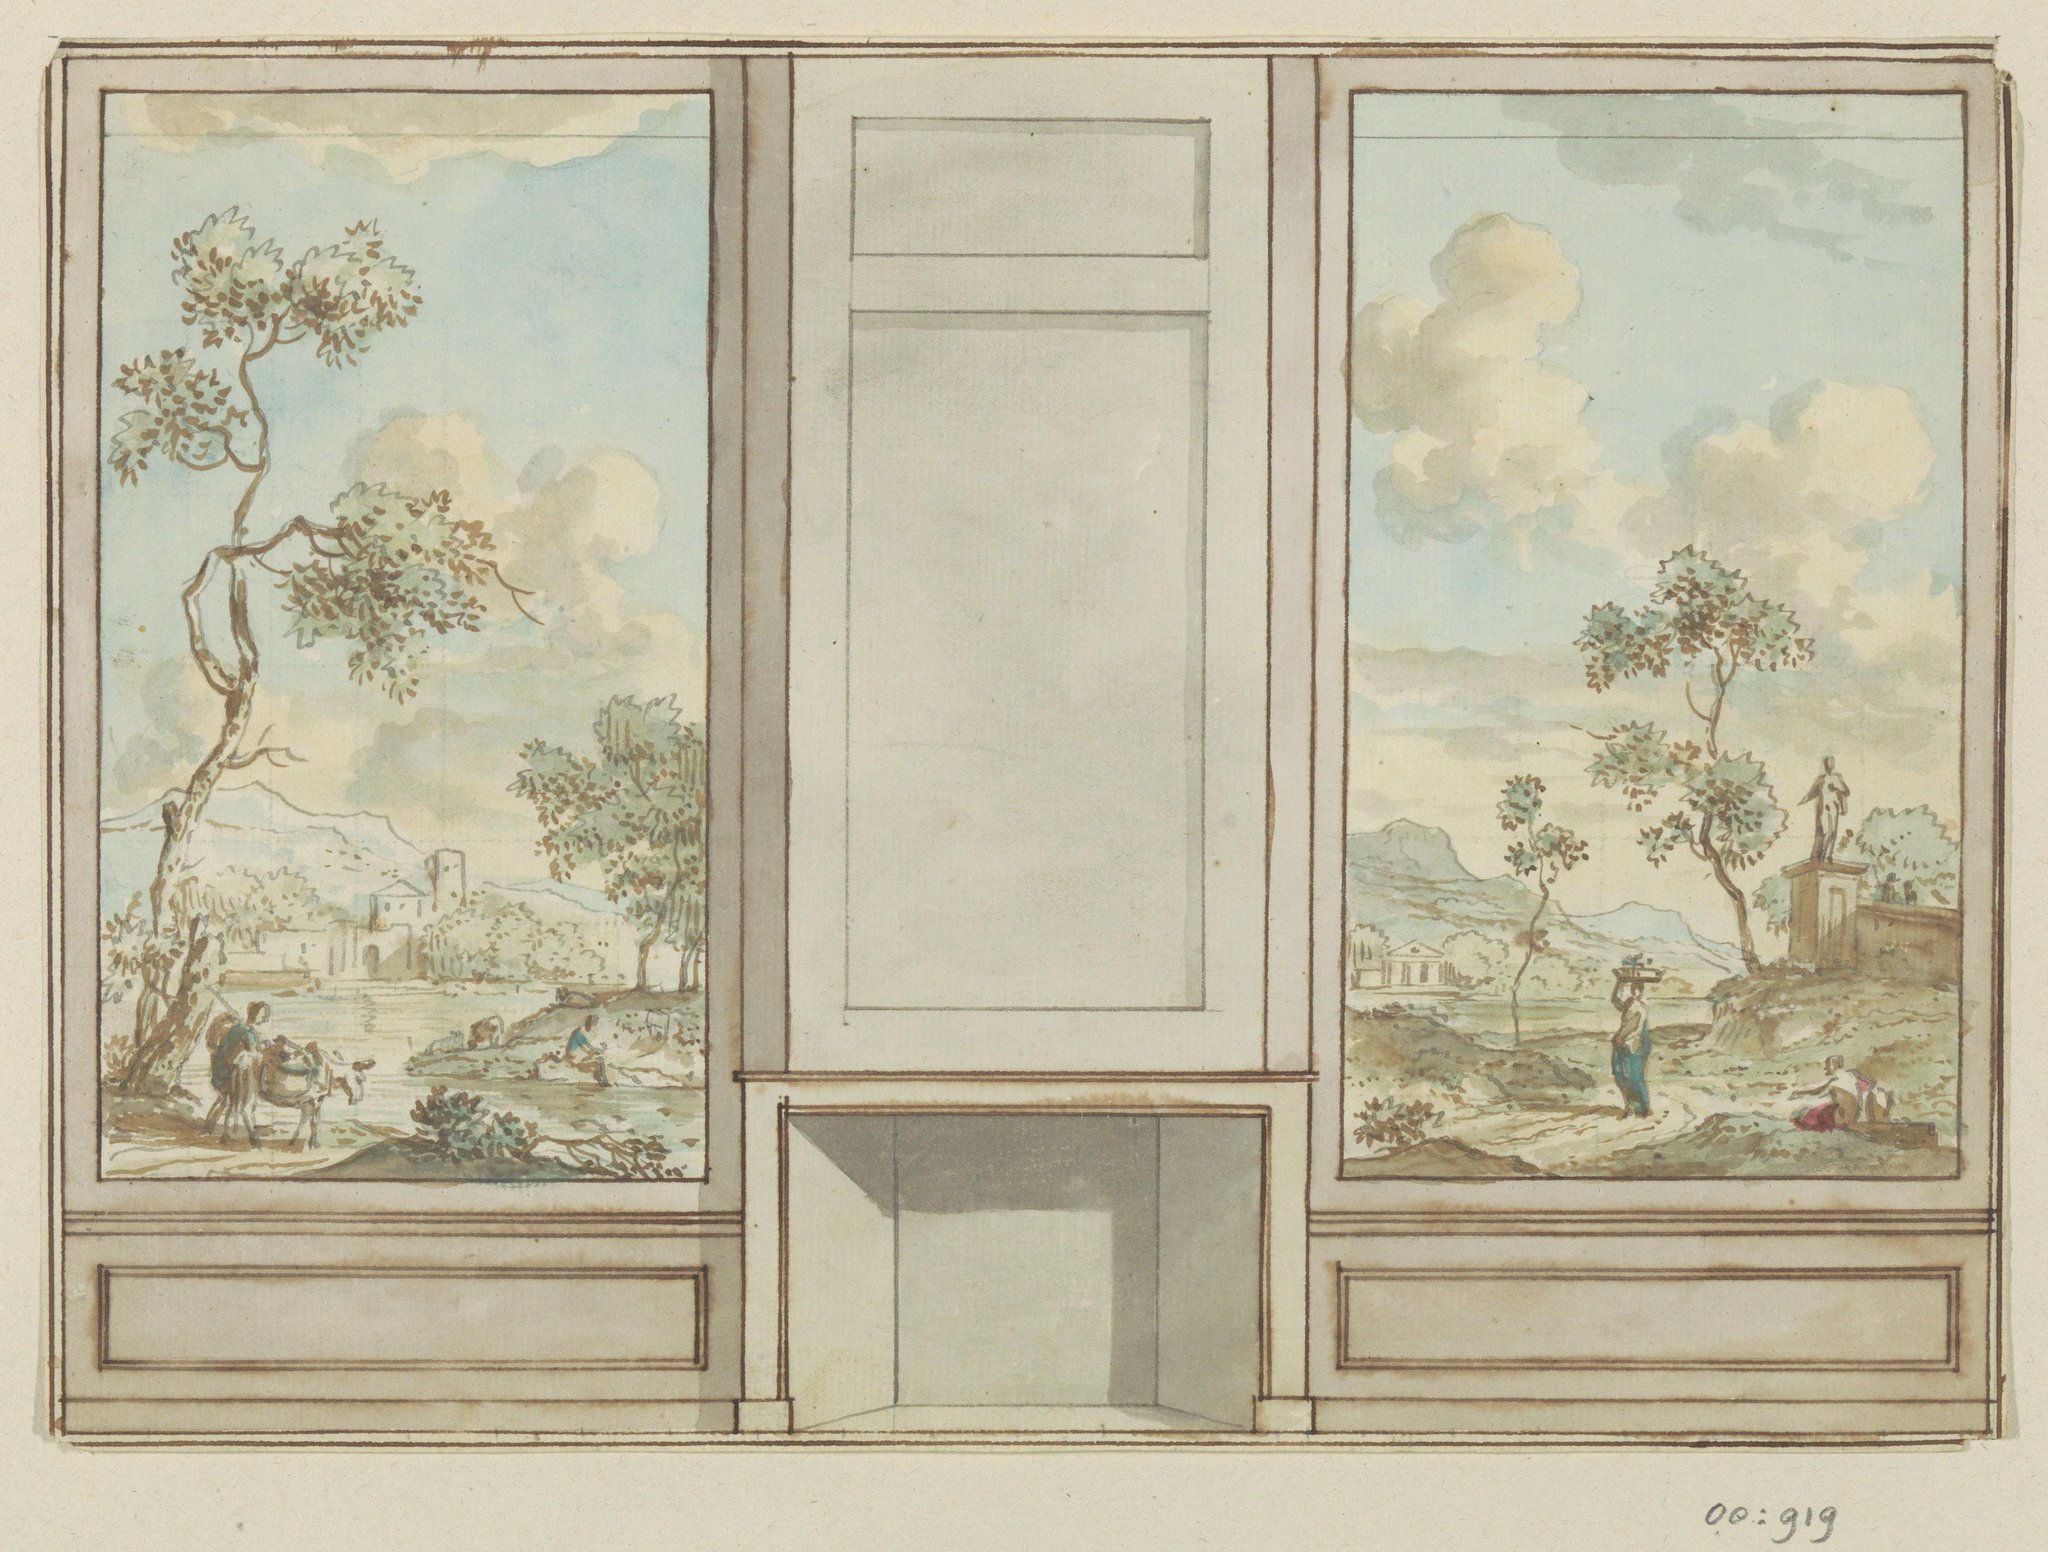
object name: album leaf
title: Ontwerptekening voor een kamerwand met schouw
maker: jurriaan andriessen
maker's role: draughtsman, painter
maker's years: 1742-1819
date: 1760-1819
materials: paint, paper, pencil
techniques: brush, pen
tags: ass, donkey, landscapes in the temperate zone, interior ~ architectural design or model, chimney-piece, mantelpiece, wall-covering, mountains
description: Met links een waterlandschap met op de voorgrond een ezeldrijver en op de achtergrond een gebouw en rechts een landschap met twee mensen en een monument. Tekening maakt deel uit van een album.